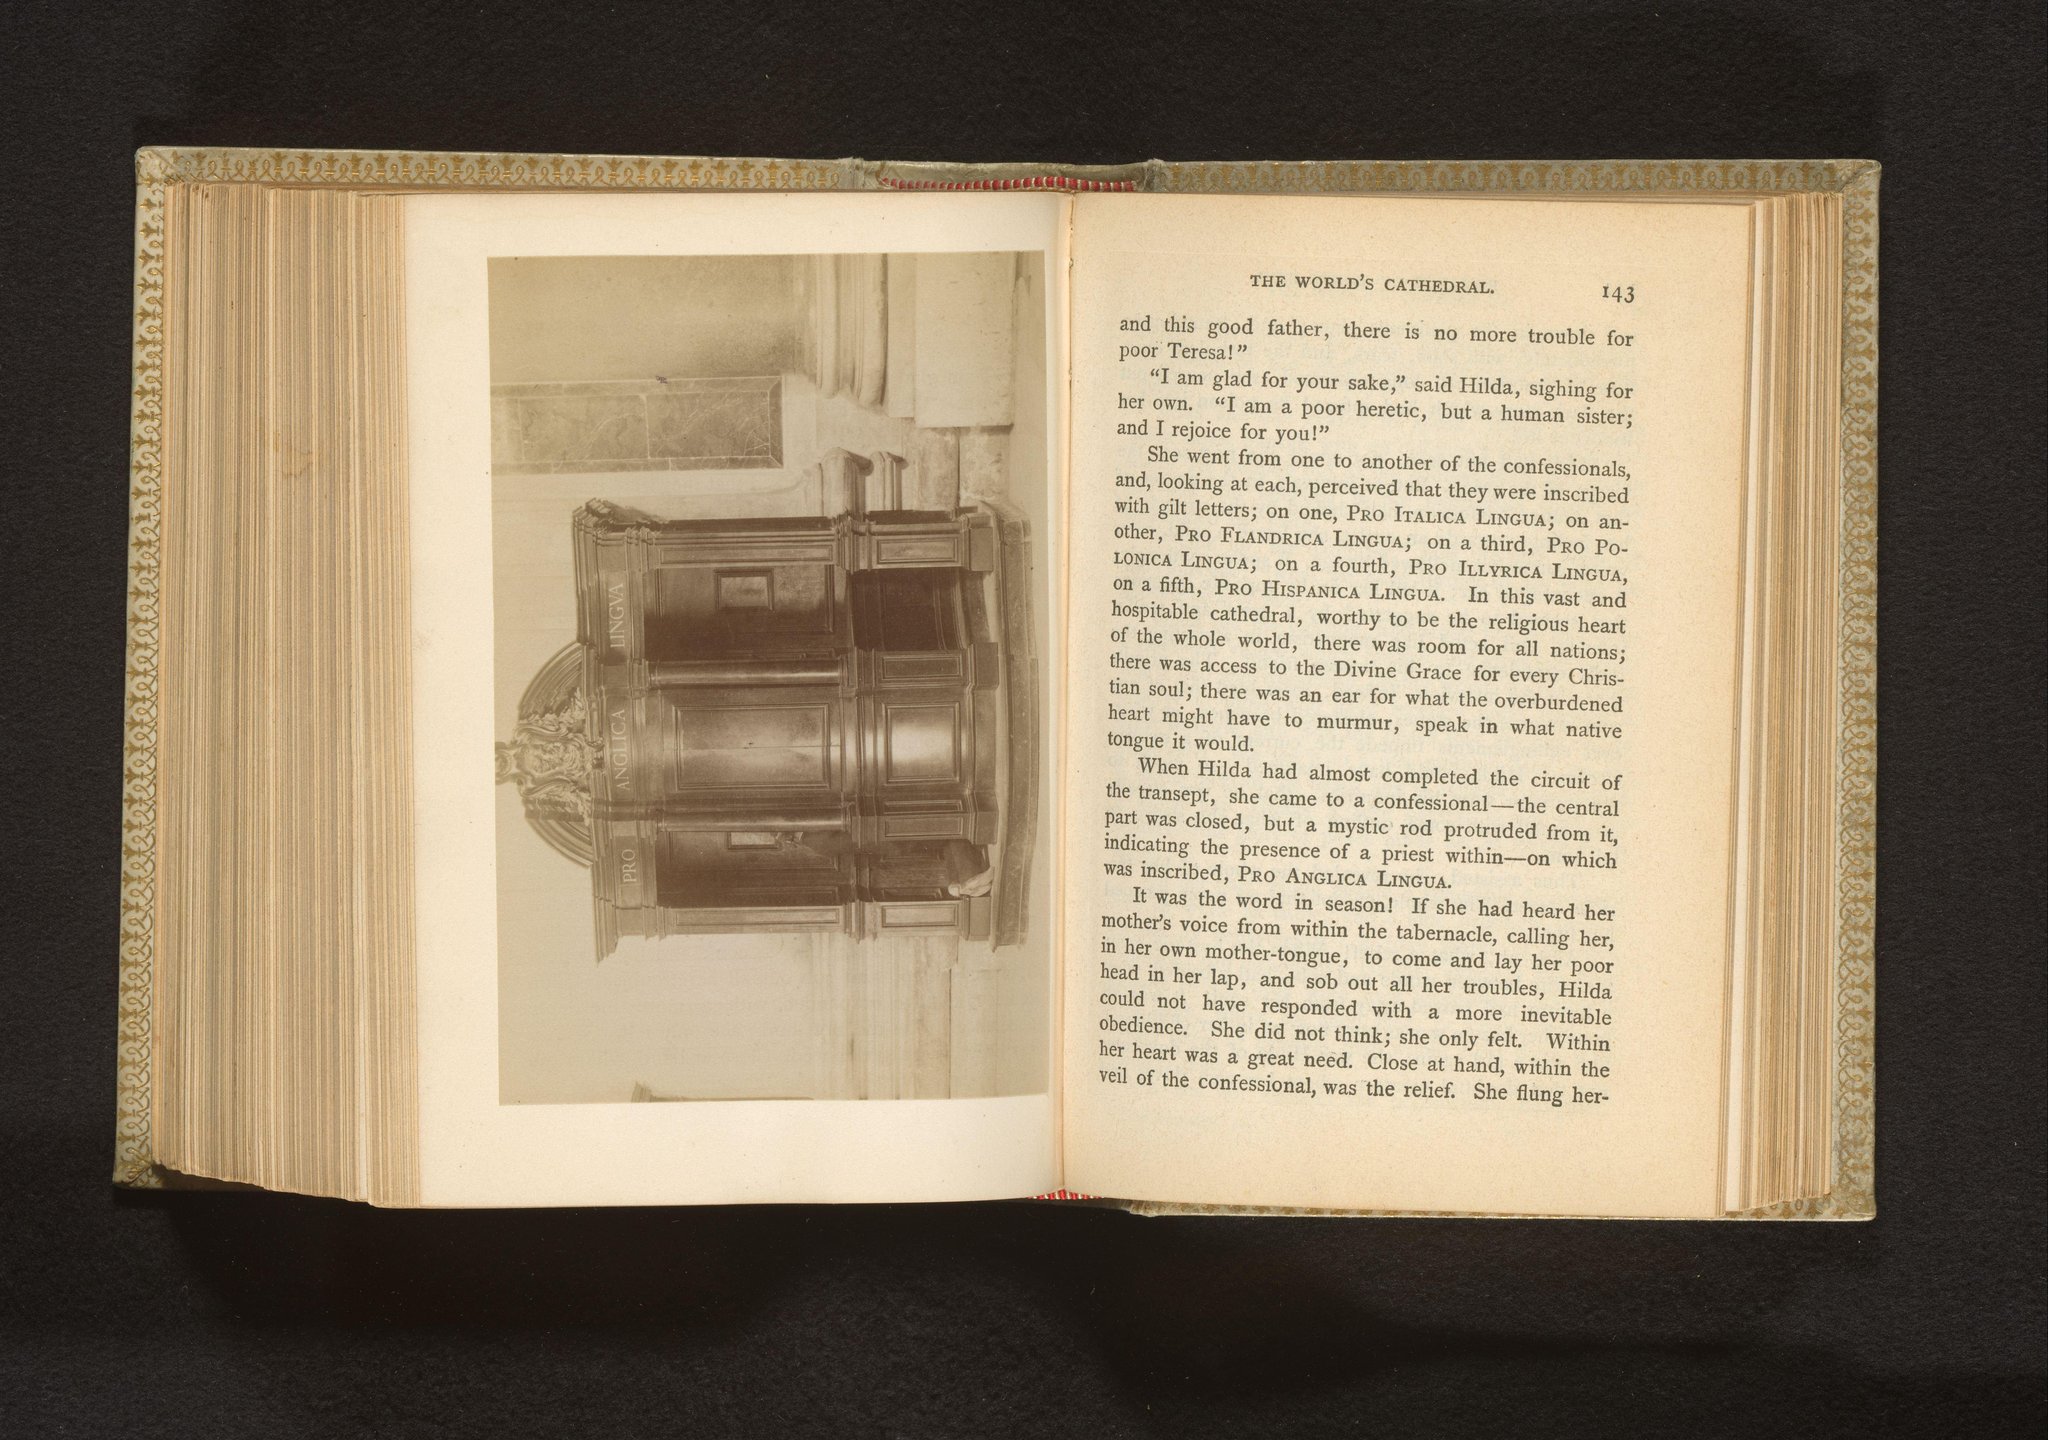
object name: page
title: Biechtstoel in de Sint-Pietersbasiliek in Vaticaanstad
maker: Anonymous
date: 1850-1860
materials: photographic support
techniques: albumen print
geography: sint-pietersbasiliek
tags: confessional ~ part of the confession